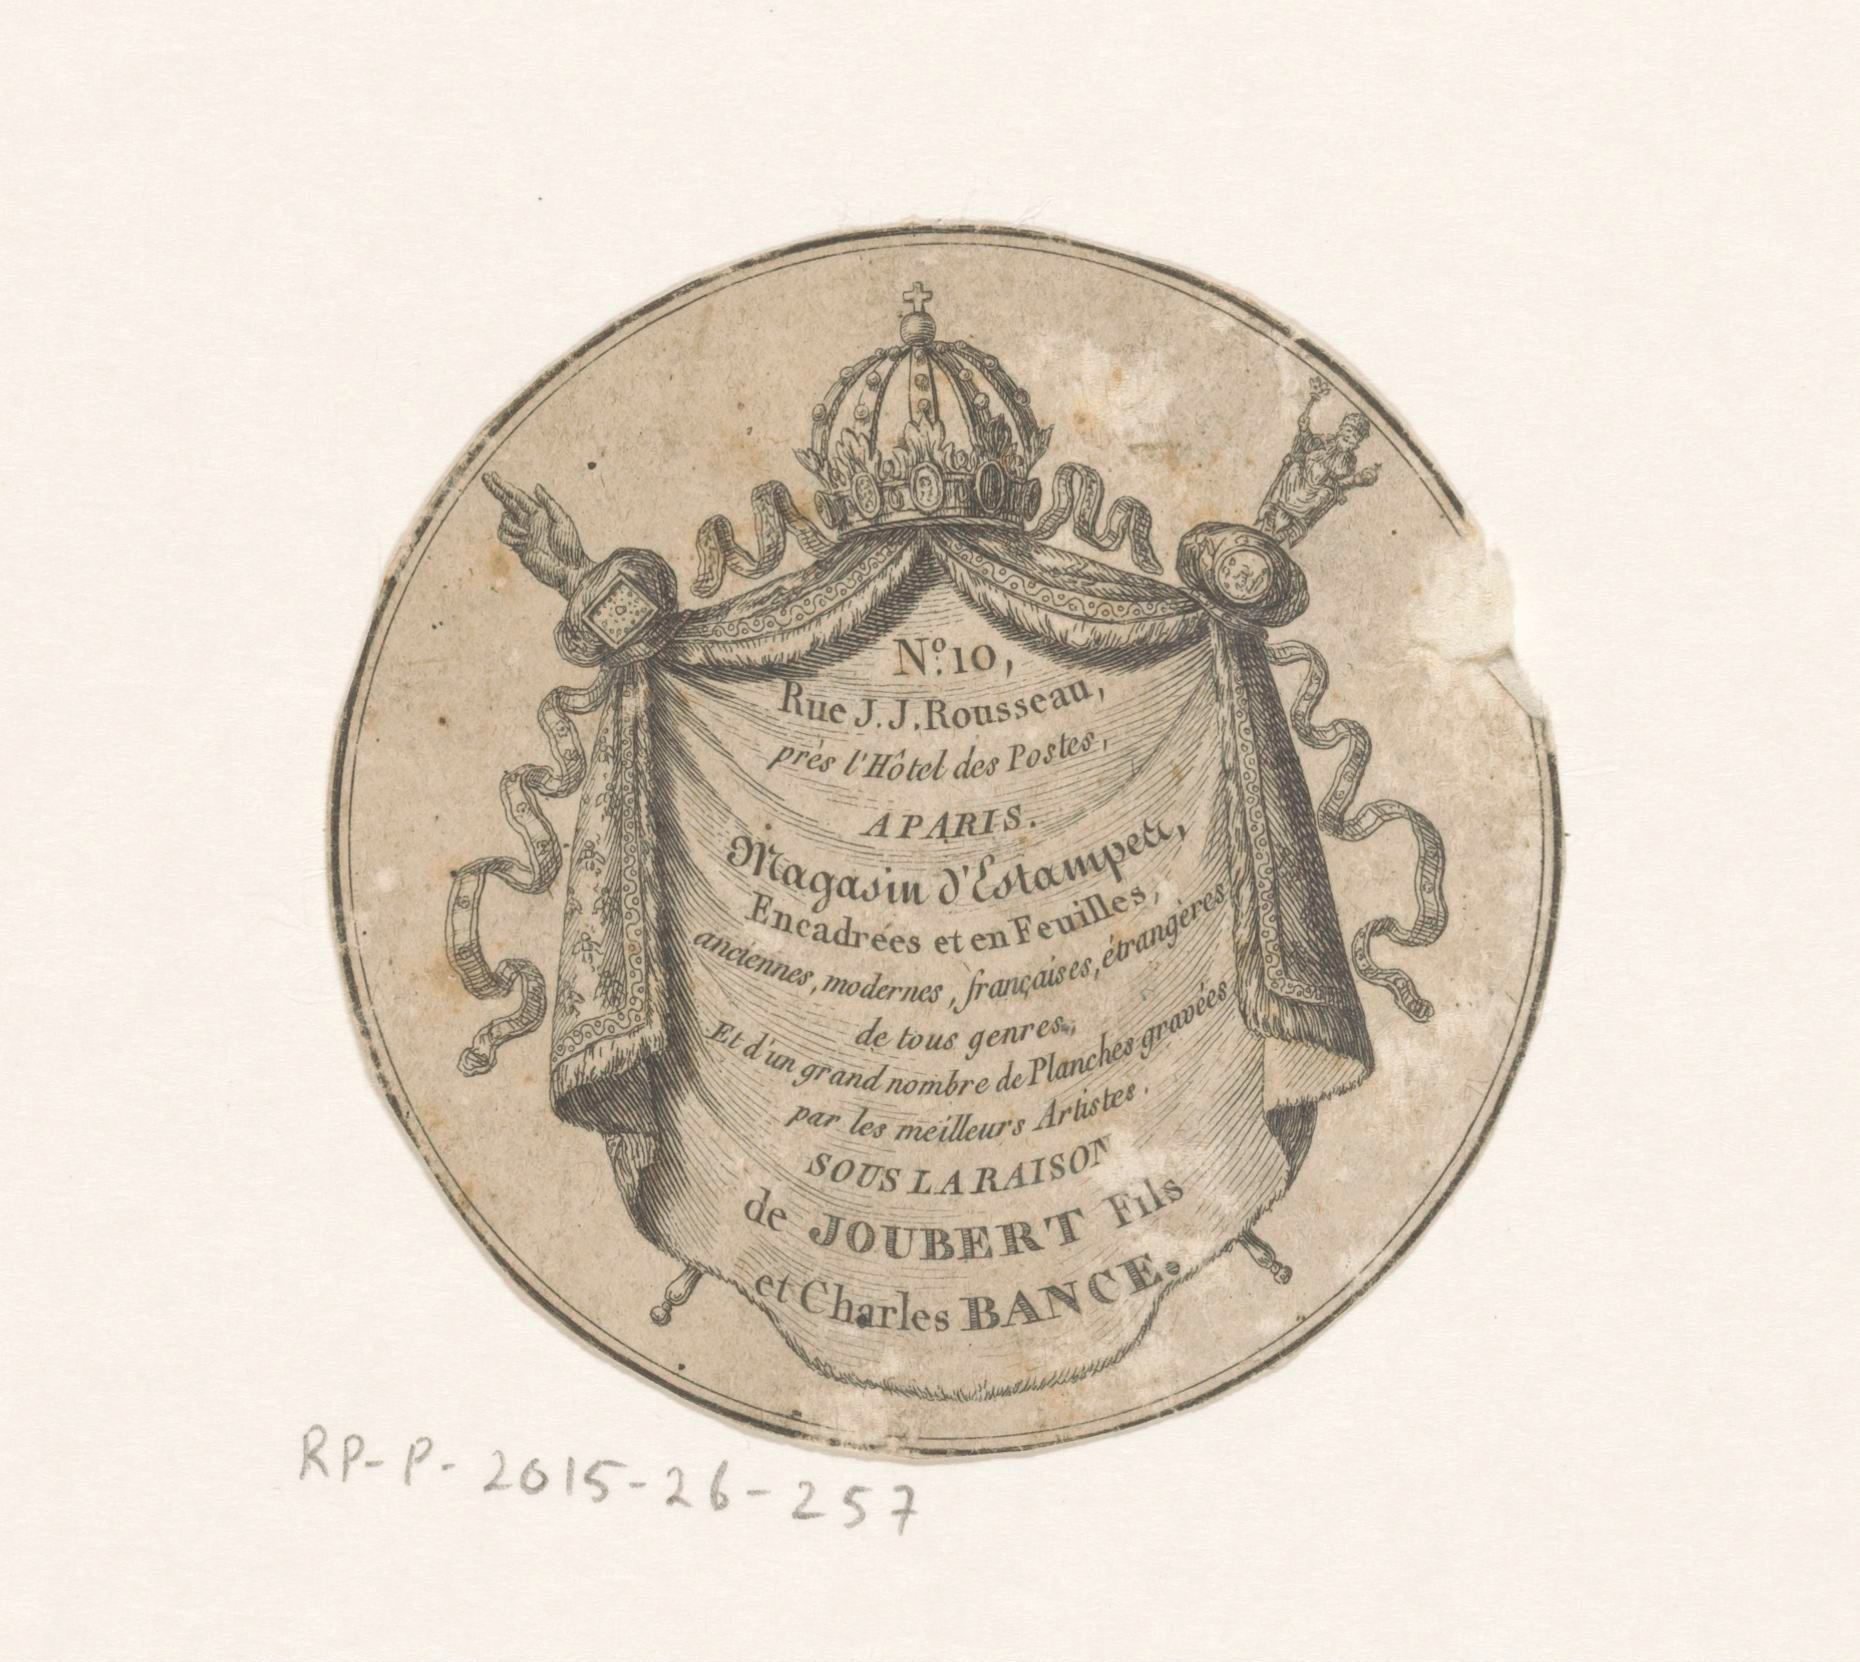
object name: label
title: Etiket van prenthandelaren Joubert Fils en Charles Bance te Parijs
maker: Anonymous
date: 1804-1815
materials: paper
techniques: engraving, etching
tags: crown (symbol of sovereignty), imperial mantle (symbol of sovereignty), sceptre, staff (symbol of sovereignty), art dealer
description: Adres aan de binnenzijde van een koningsmantel, omgeven door regalia. De mantel aan de buitenkant versierd met bijen, aan de bovenkant een kroon, links de hand van justitie en rechts een scepter met een vorst met rijksappel. Deze combinatie was in gebruik in het Eerste Franse Keizerrijk (1804-1815).